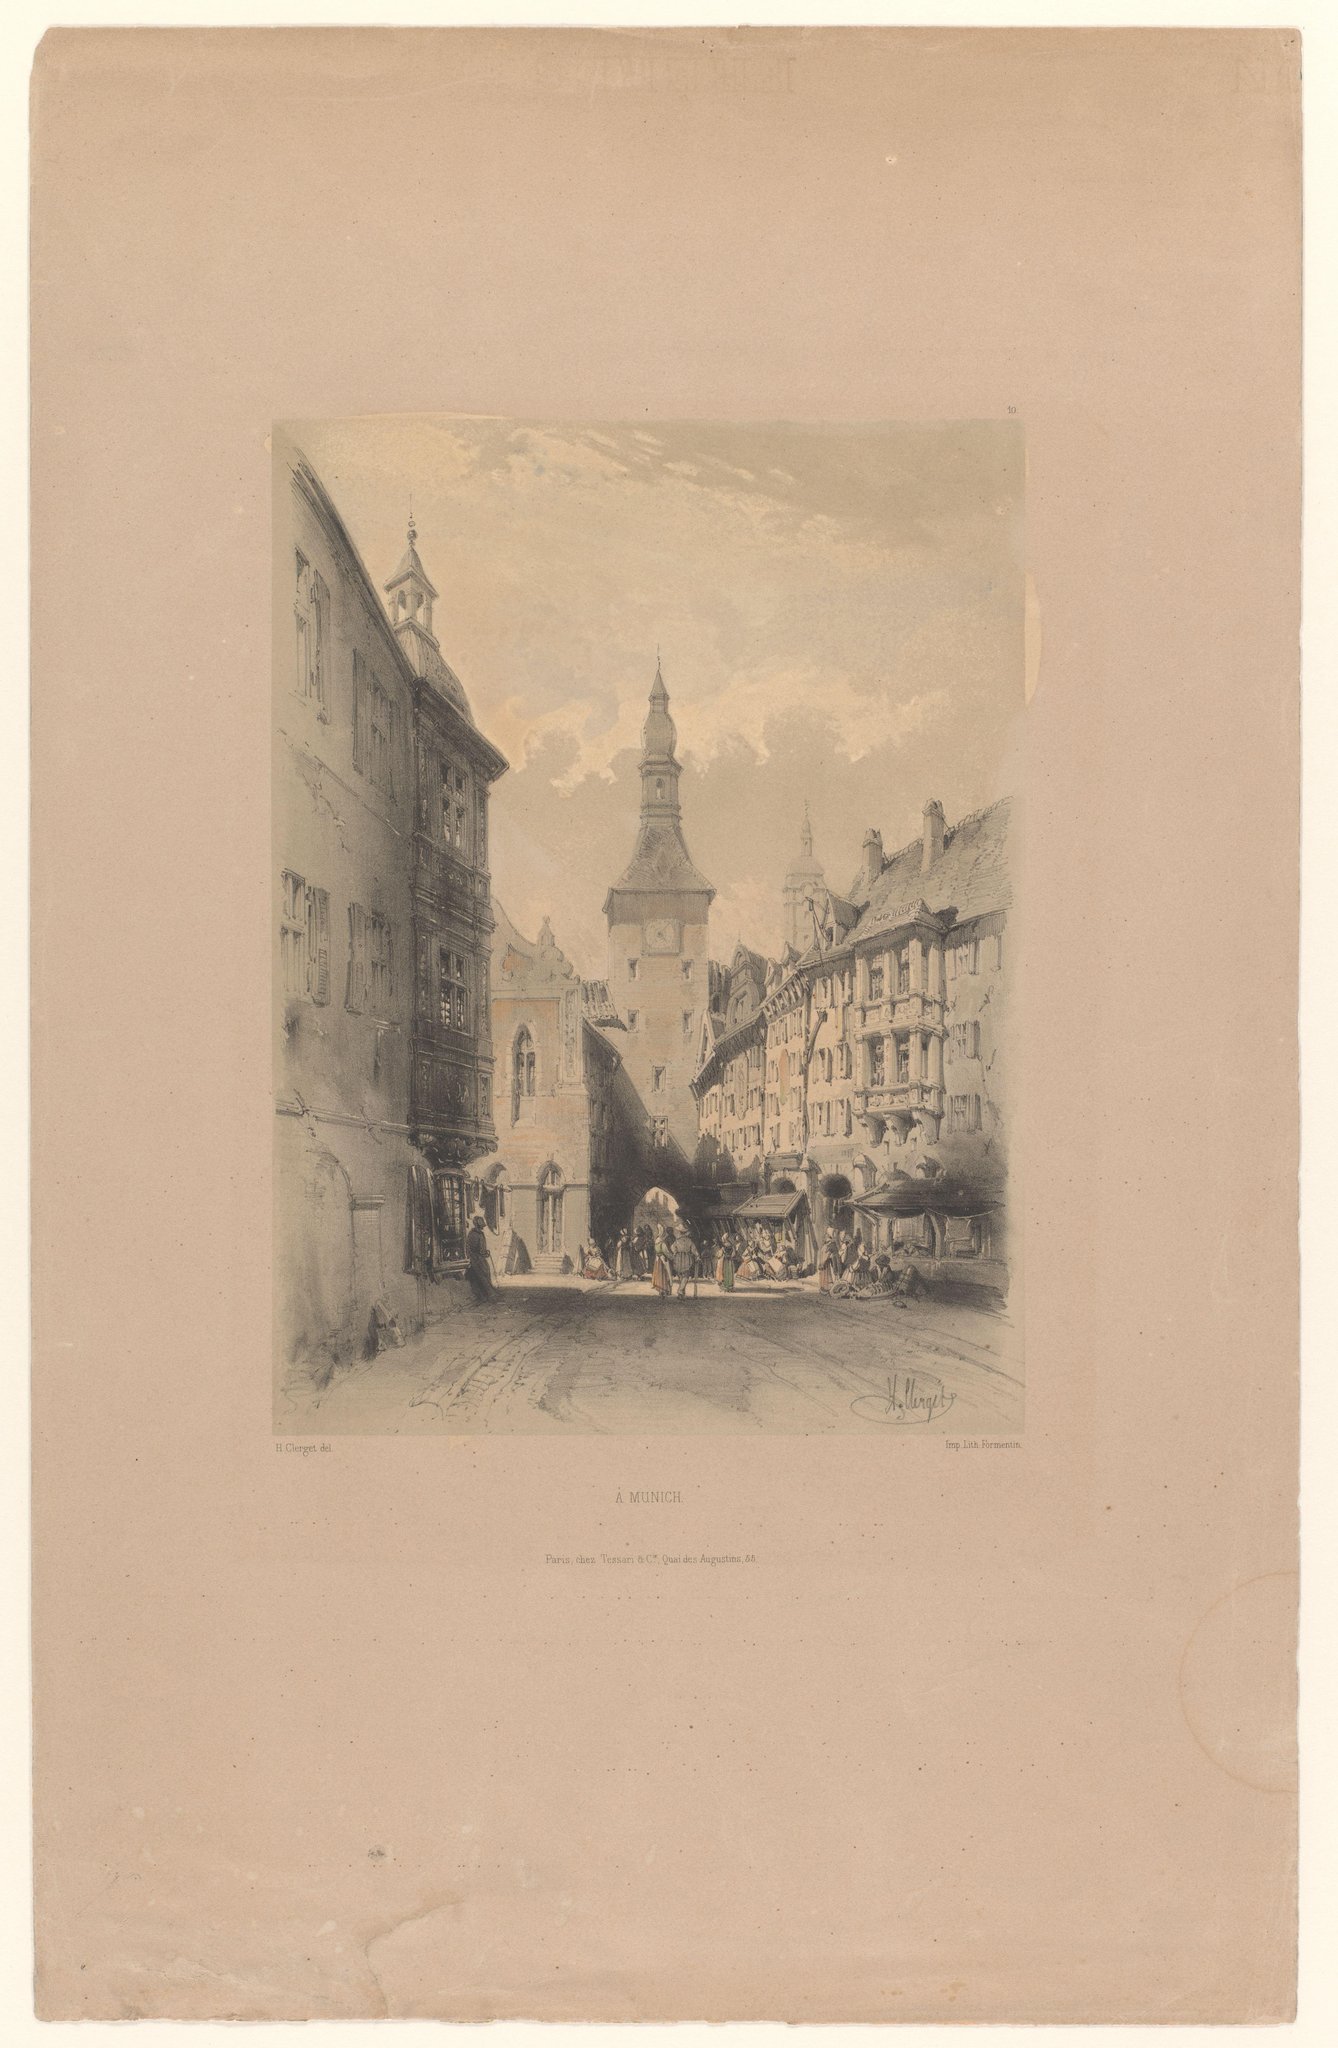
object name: print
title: À Munich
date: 1840-1882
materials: paper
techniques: lithograph, hand coloring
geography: paris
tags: parts of church exterior and annexes: spire, street (+ city(-scape) with figures, staffage)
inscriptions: collector's mark: Lugt 2228a